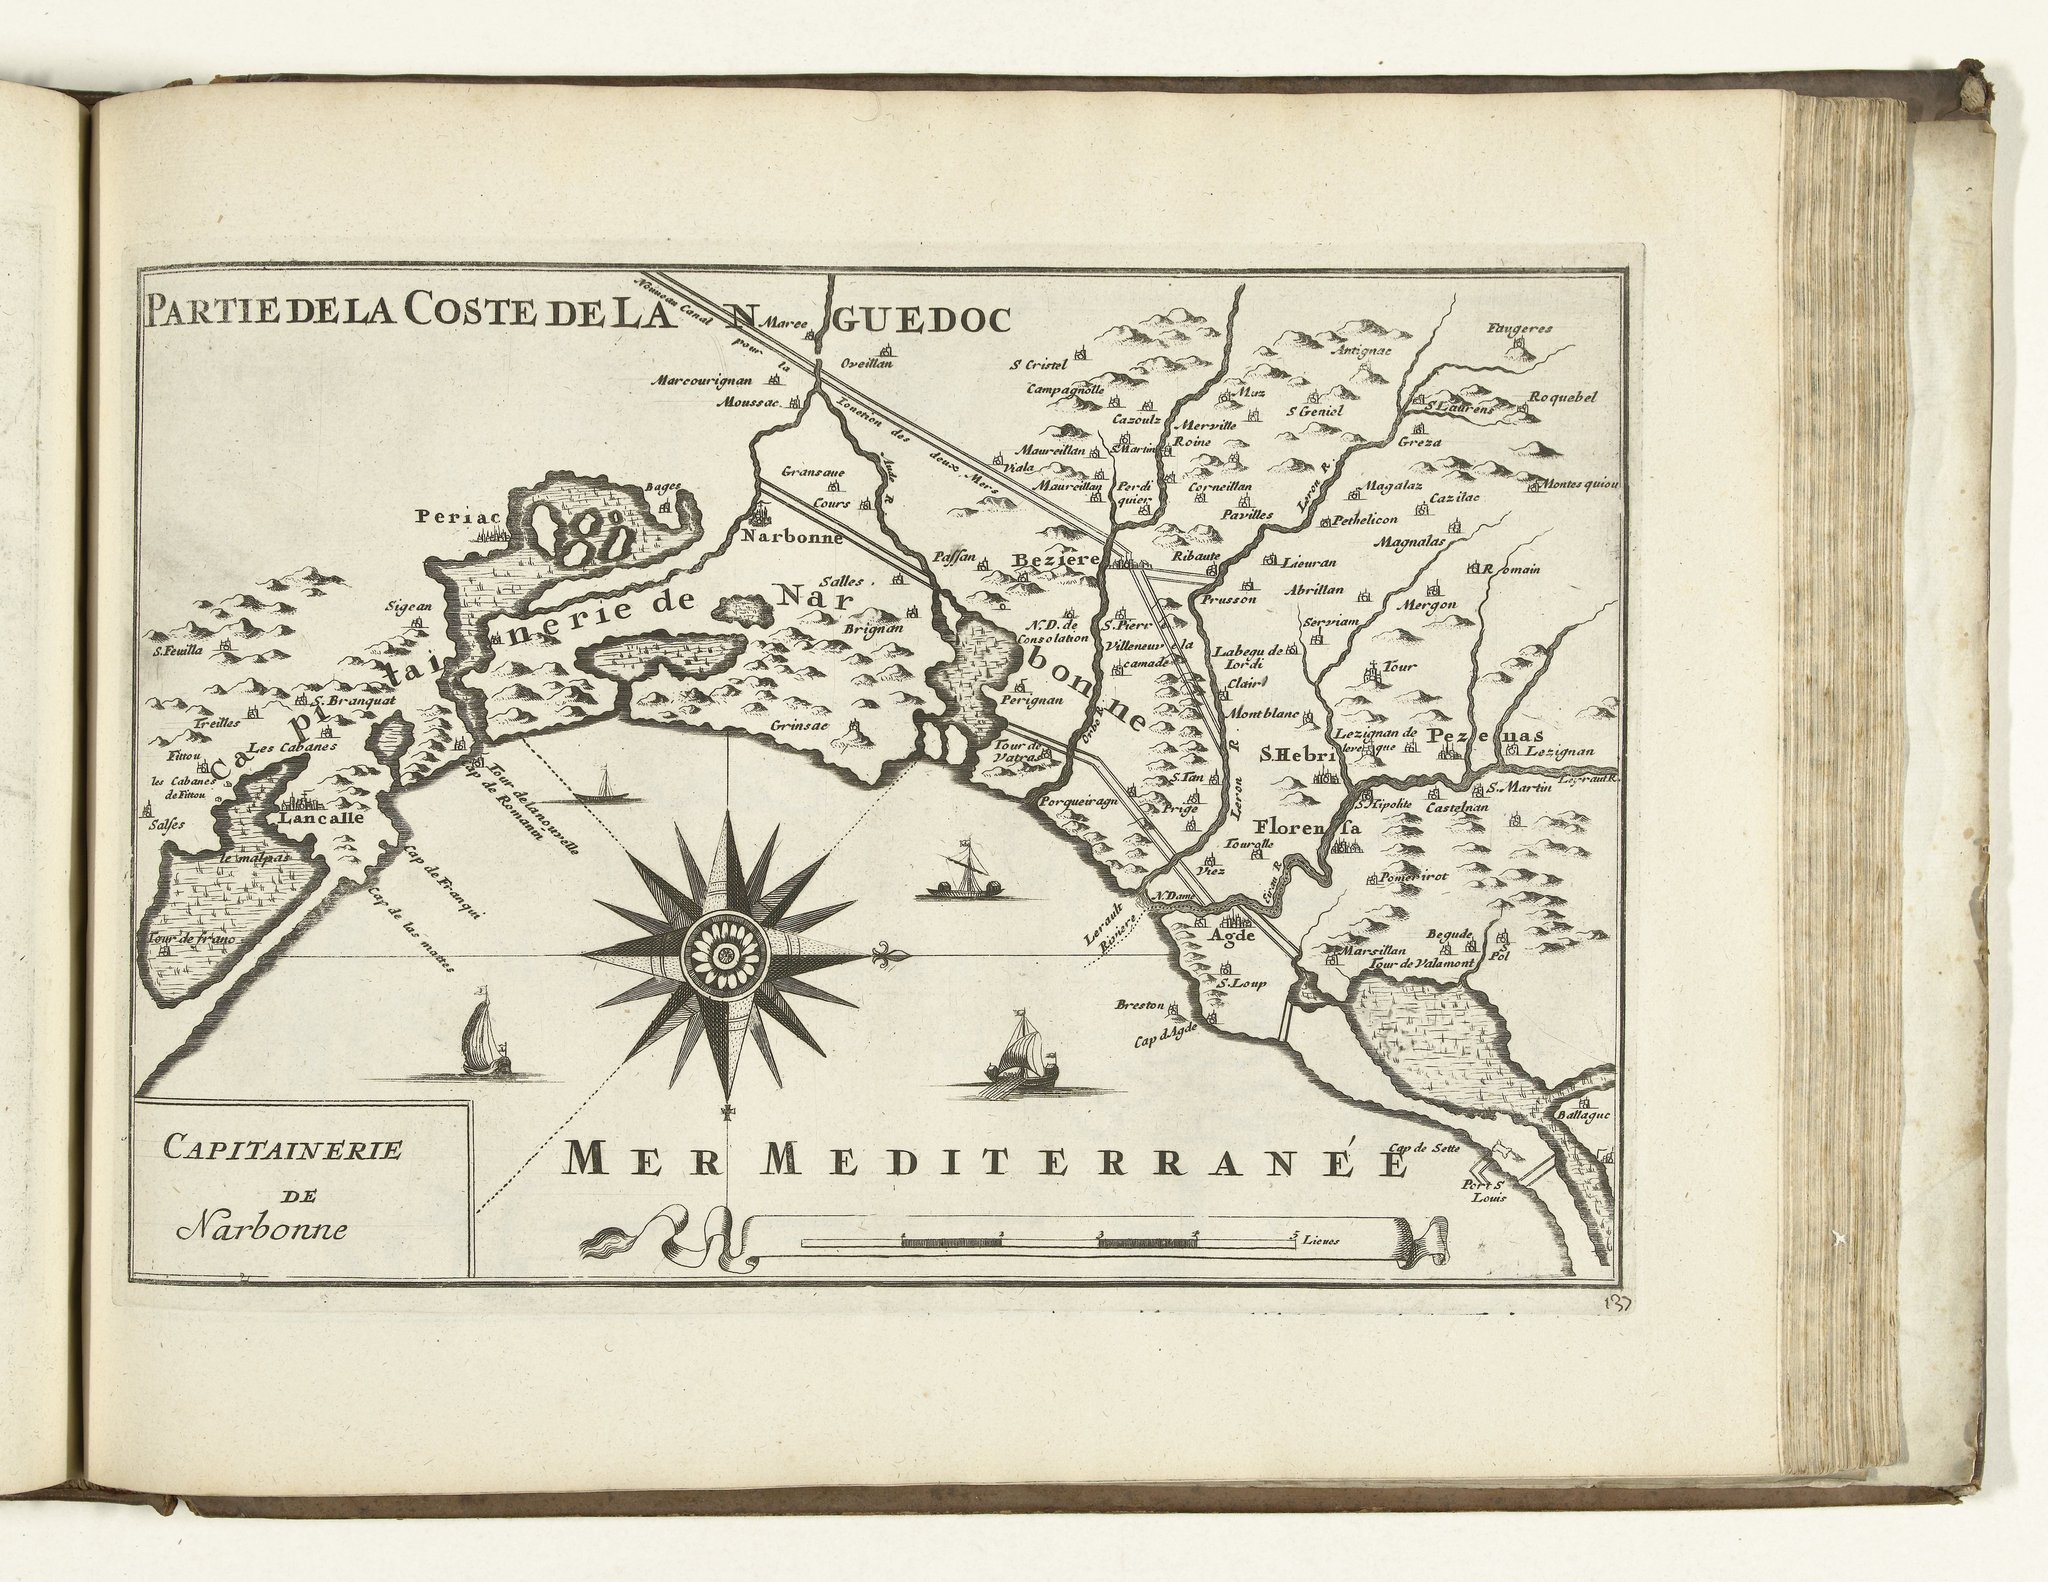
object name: map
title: Les Forces de l'Europe, Asie, Afrique et Amerique (...) Comme aussi les Cartes des Côtes de France et d'Espagne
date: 1726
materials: paper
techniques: engraving, etching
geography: leiden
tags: maps of separate countries or regions, france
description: Kaart van de Franse zuidkust bij Narbonne. Plaat nr. 137 in deel VI van het prentwerk: Les Forces de l'Europe, Asie, Afrique et Amerique ... Comme aussi les Cartes des Côtes de France et d'Espagne uit 1726, dit eerste deel met 238 met de hand genummerde platen van vermaarde sterke steden en vestingen in het kader van de Spaanse Successieoorlog 1701-1713. Voor het merendeel zijn deze platen gekopieerd naar de anonieme Franse platen van vermaarde sterke steden en vestingen: in Les forces de l'Europe en in: Le theatre de la guerre, dans les Pays-Bas, beide oorspronkelijk uitgegeven door Nicolas de Fer te Parijs (1693-1697) in het kader van de Negenjarige Oorlog. Titel en opschriften in het Frans.